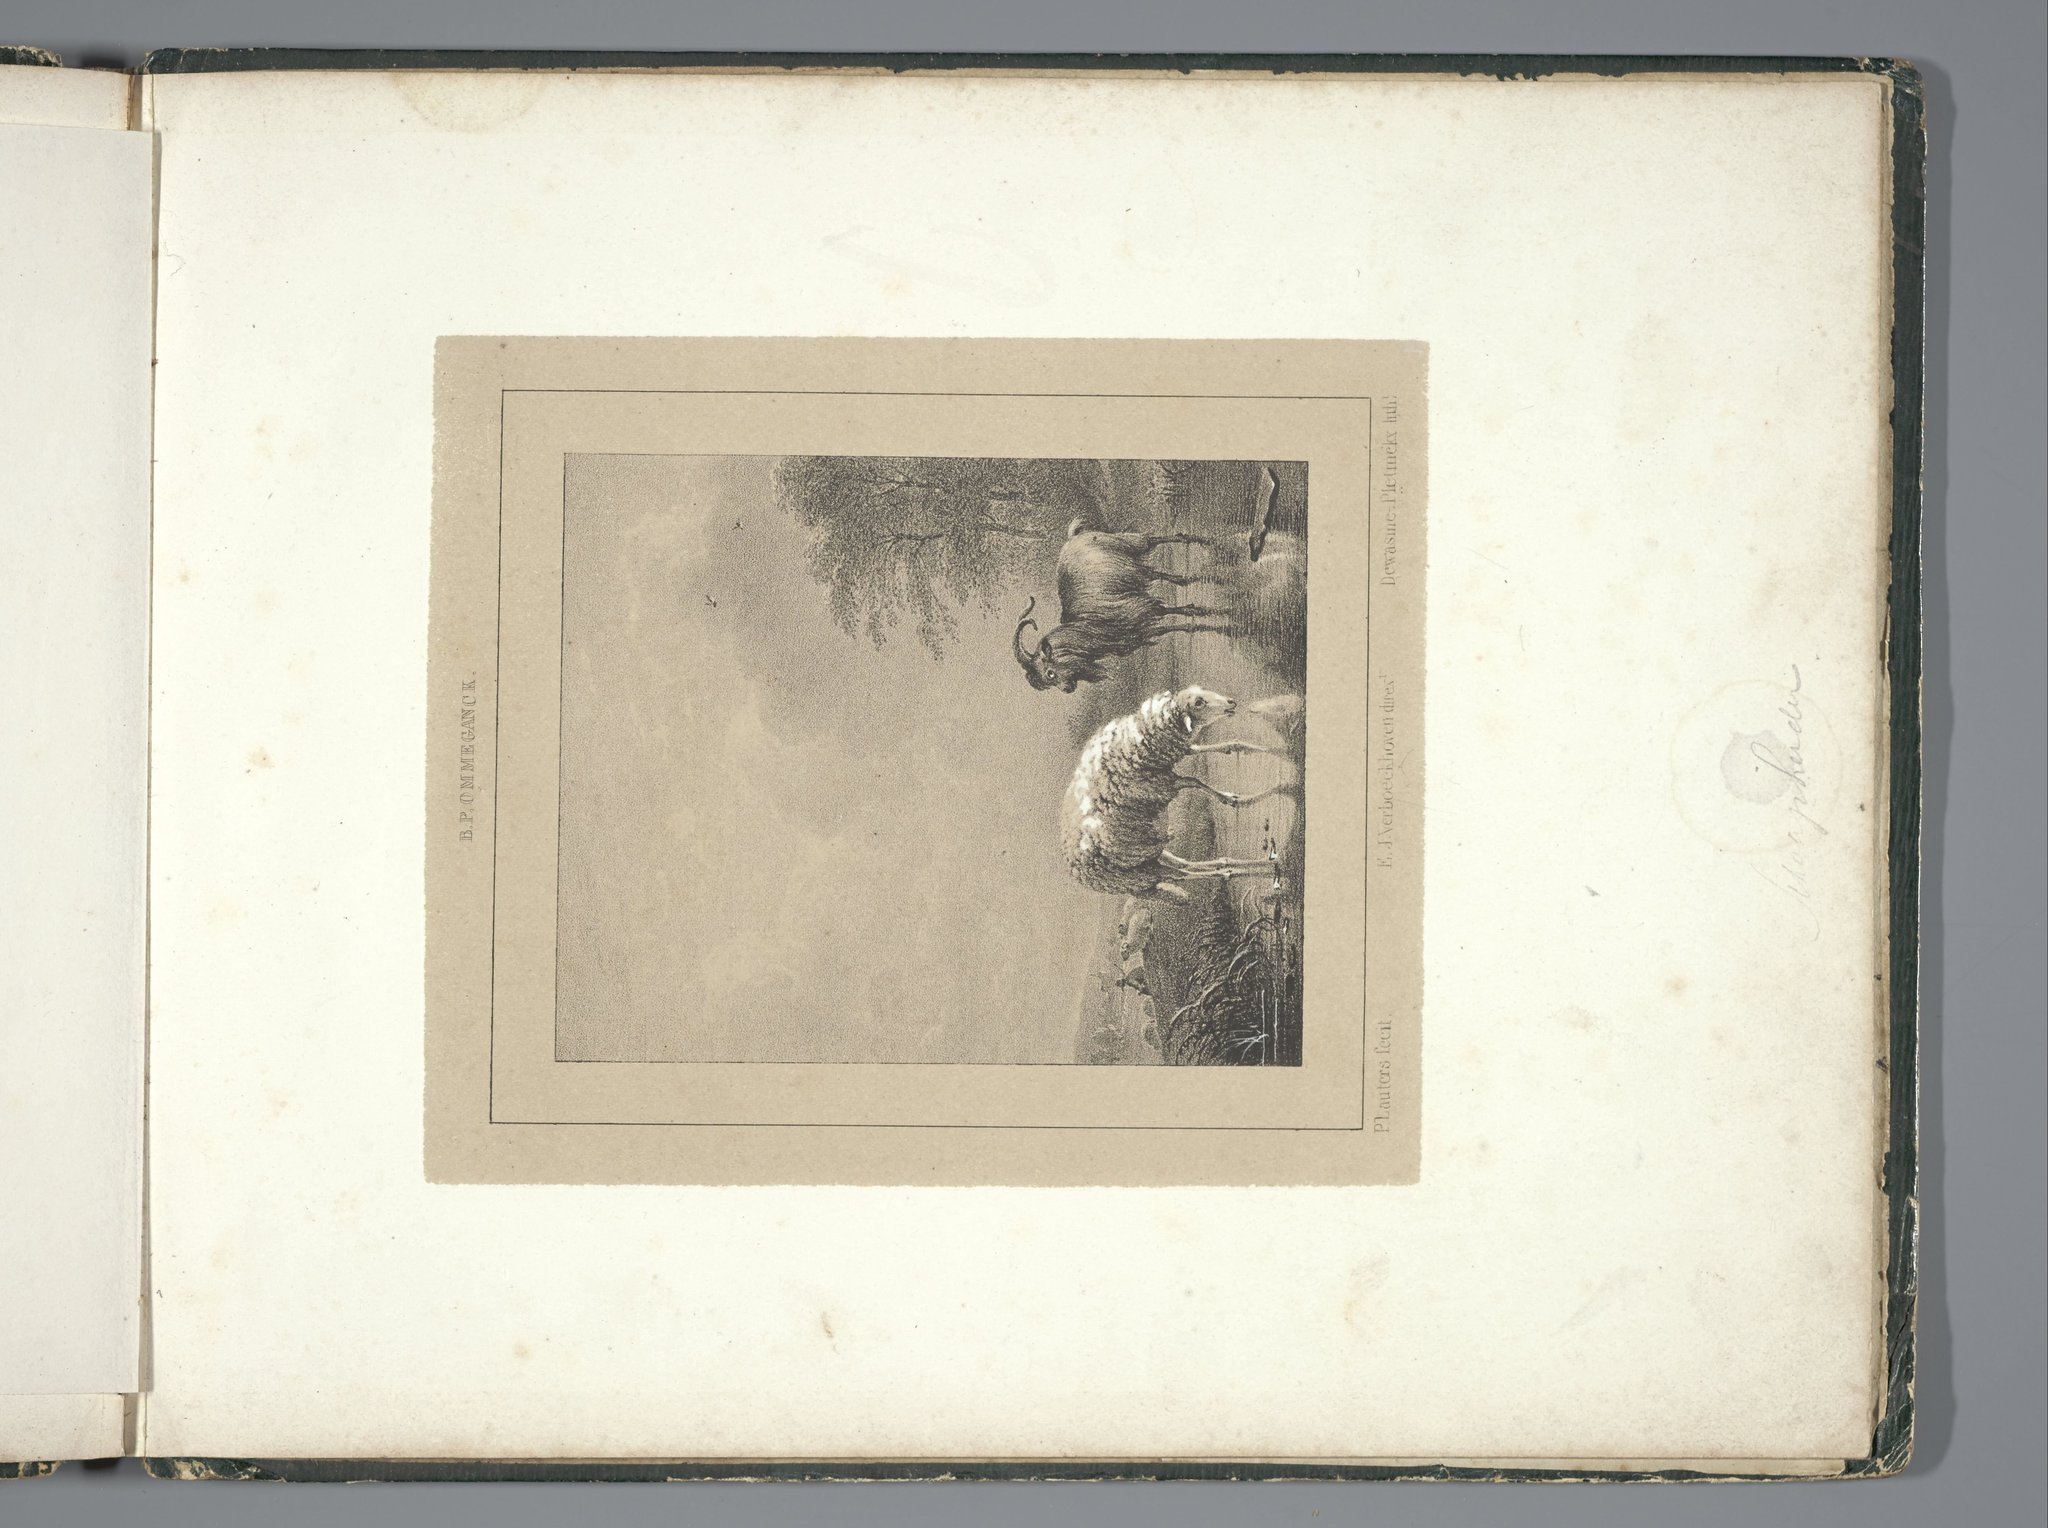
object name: print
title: Schaapherder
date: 1830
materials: paper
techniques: lithograph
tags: herding, herdsman, herdswoman, shepherd, shepherdess, cowherd, etc.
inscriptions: inscription: ‘Schaapherder’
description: Prent uit album met twaalf vroege lithografieën geproduceerd door de firma Dewasme-Pletinckx te Brussel naar J.C. Schotel, E.J. Verboeckhoven, B.J. van Hove en andere eigentijdse meesters in originele band.